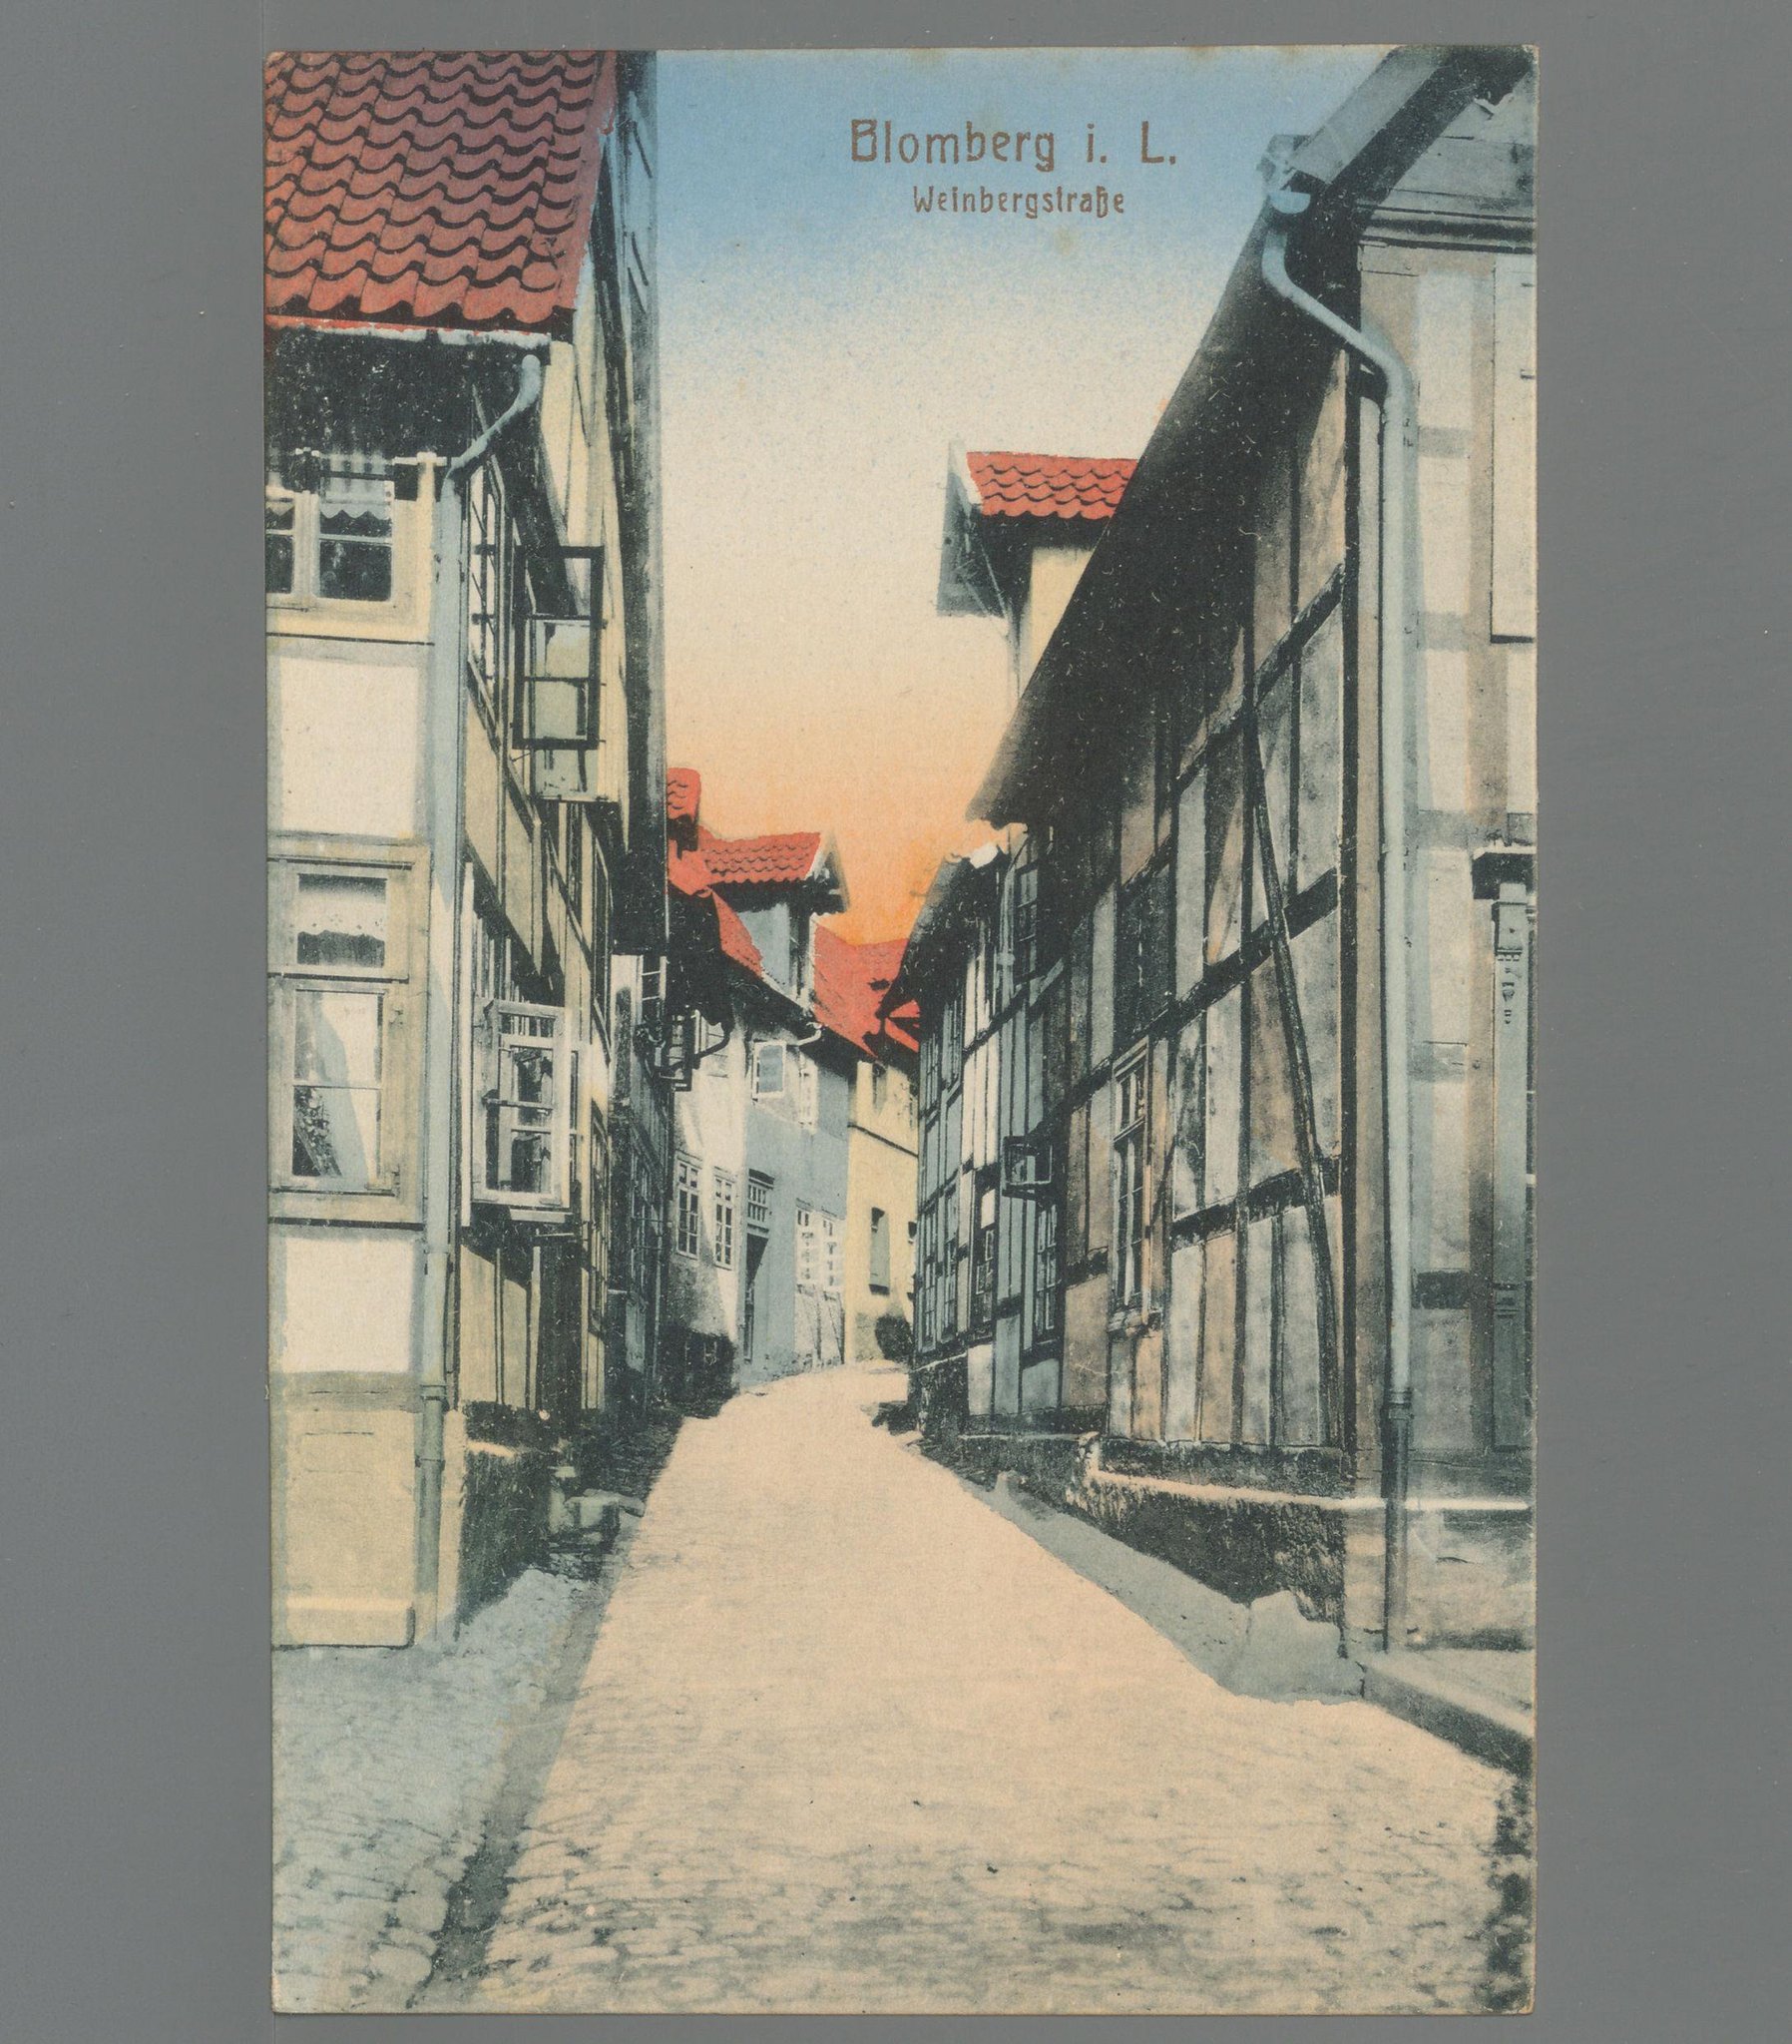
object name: photomechanical print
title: Blomberg i. L. Weinbergstraβe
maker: Anonymous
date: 1905-1930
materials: cardboard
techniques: photograph, lithograph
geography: blomberg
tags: street